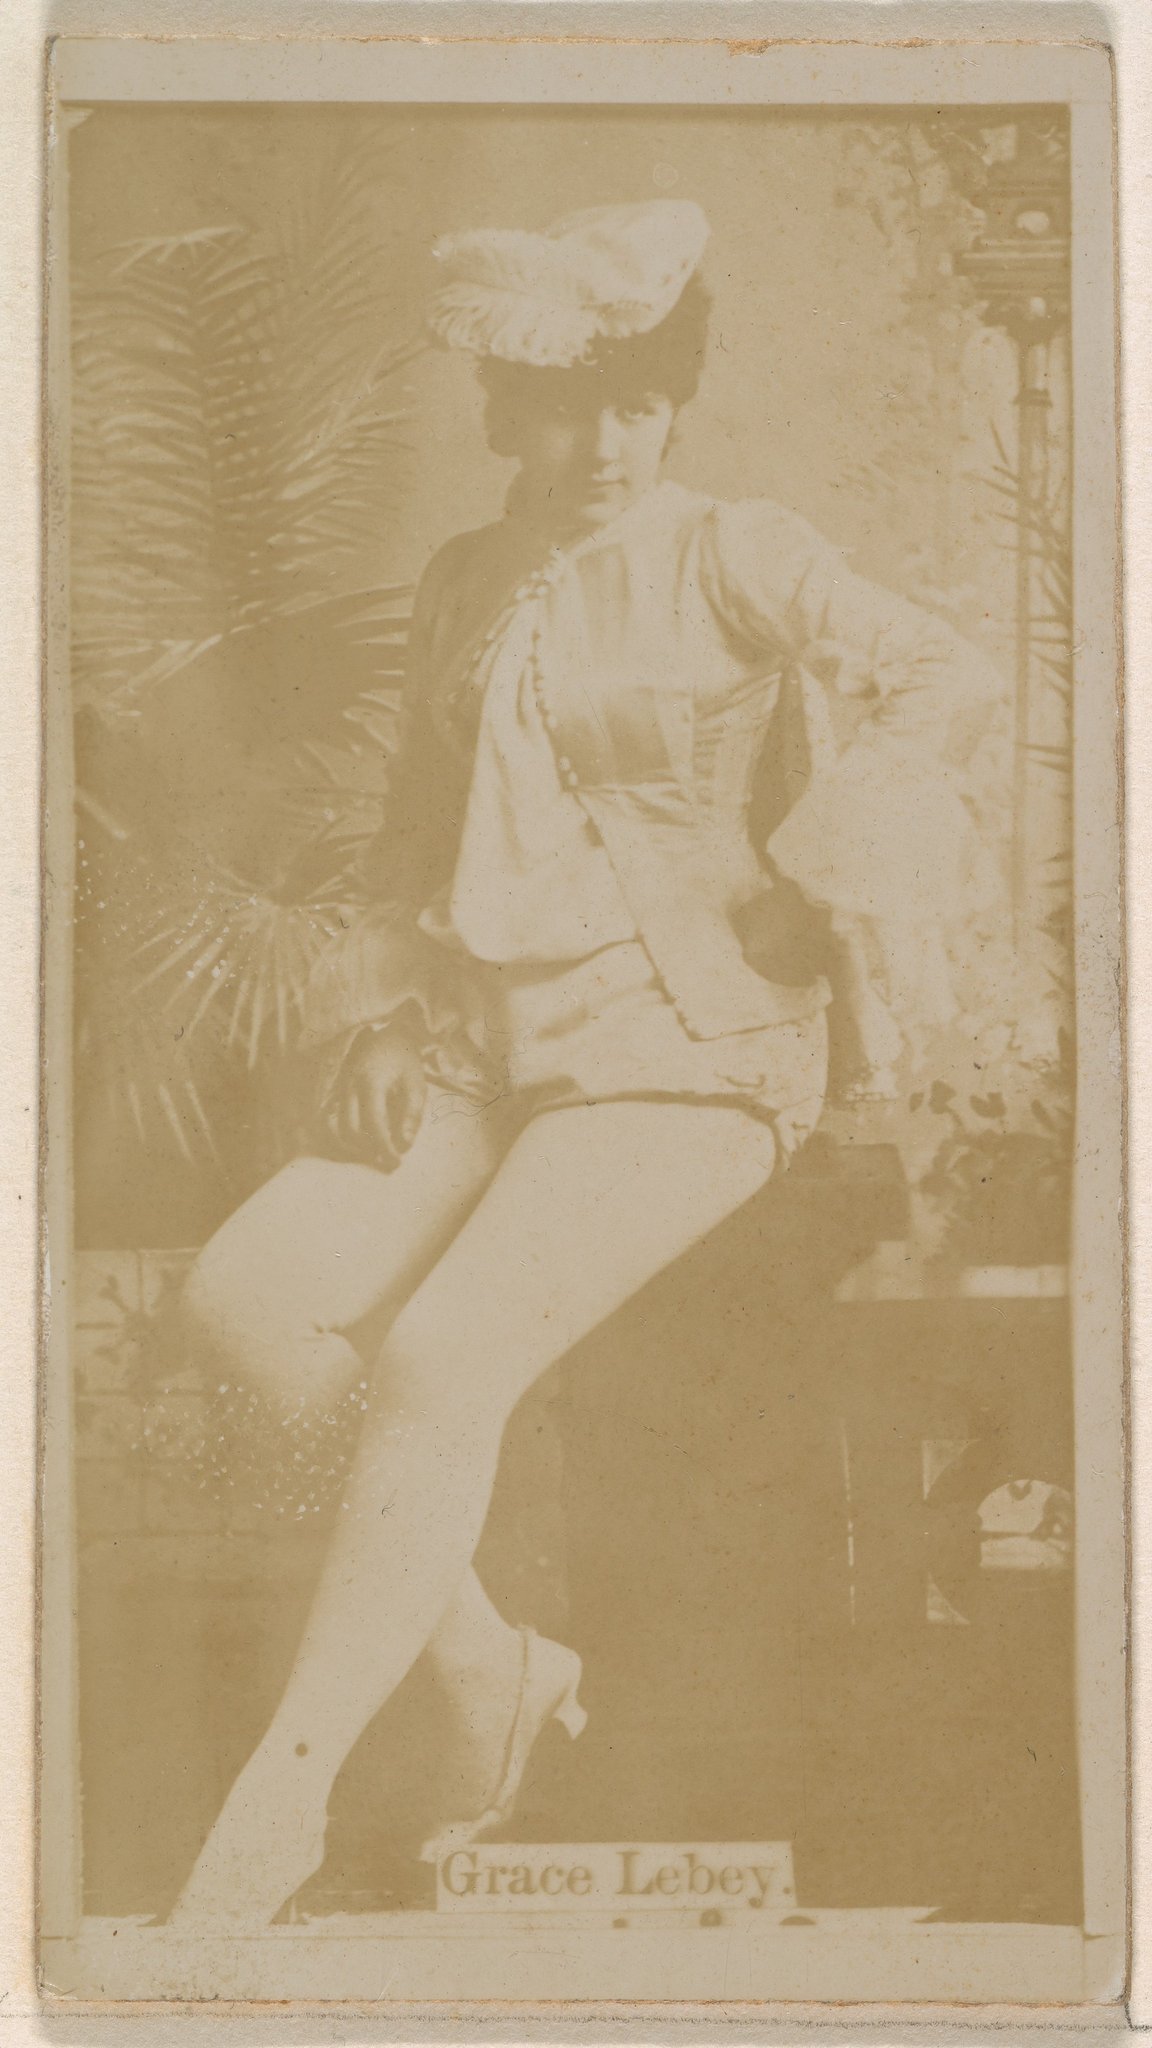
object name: photograph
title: Grace Lebey, from the Actresses series (N245) issued by Kinney Brothers to promote Sweet Caporal Cigarettes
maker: kinney brothers tobacco company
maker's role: publisher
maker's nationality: american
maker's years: 1869-2011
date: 1890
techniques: albumen silver print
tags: portraits,women,actresses